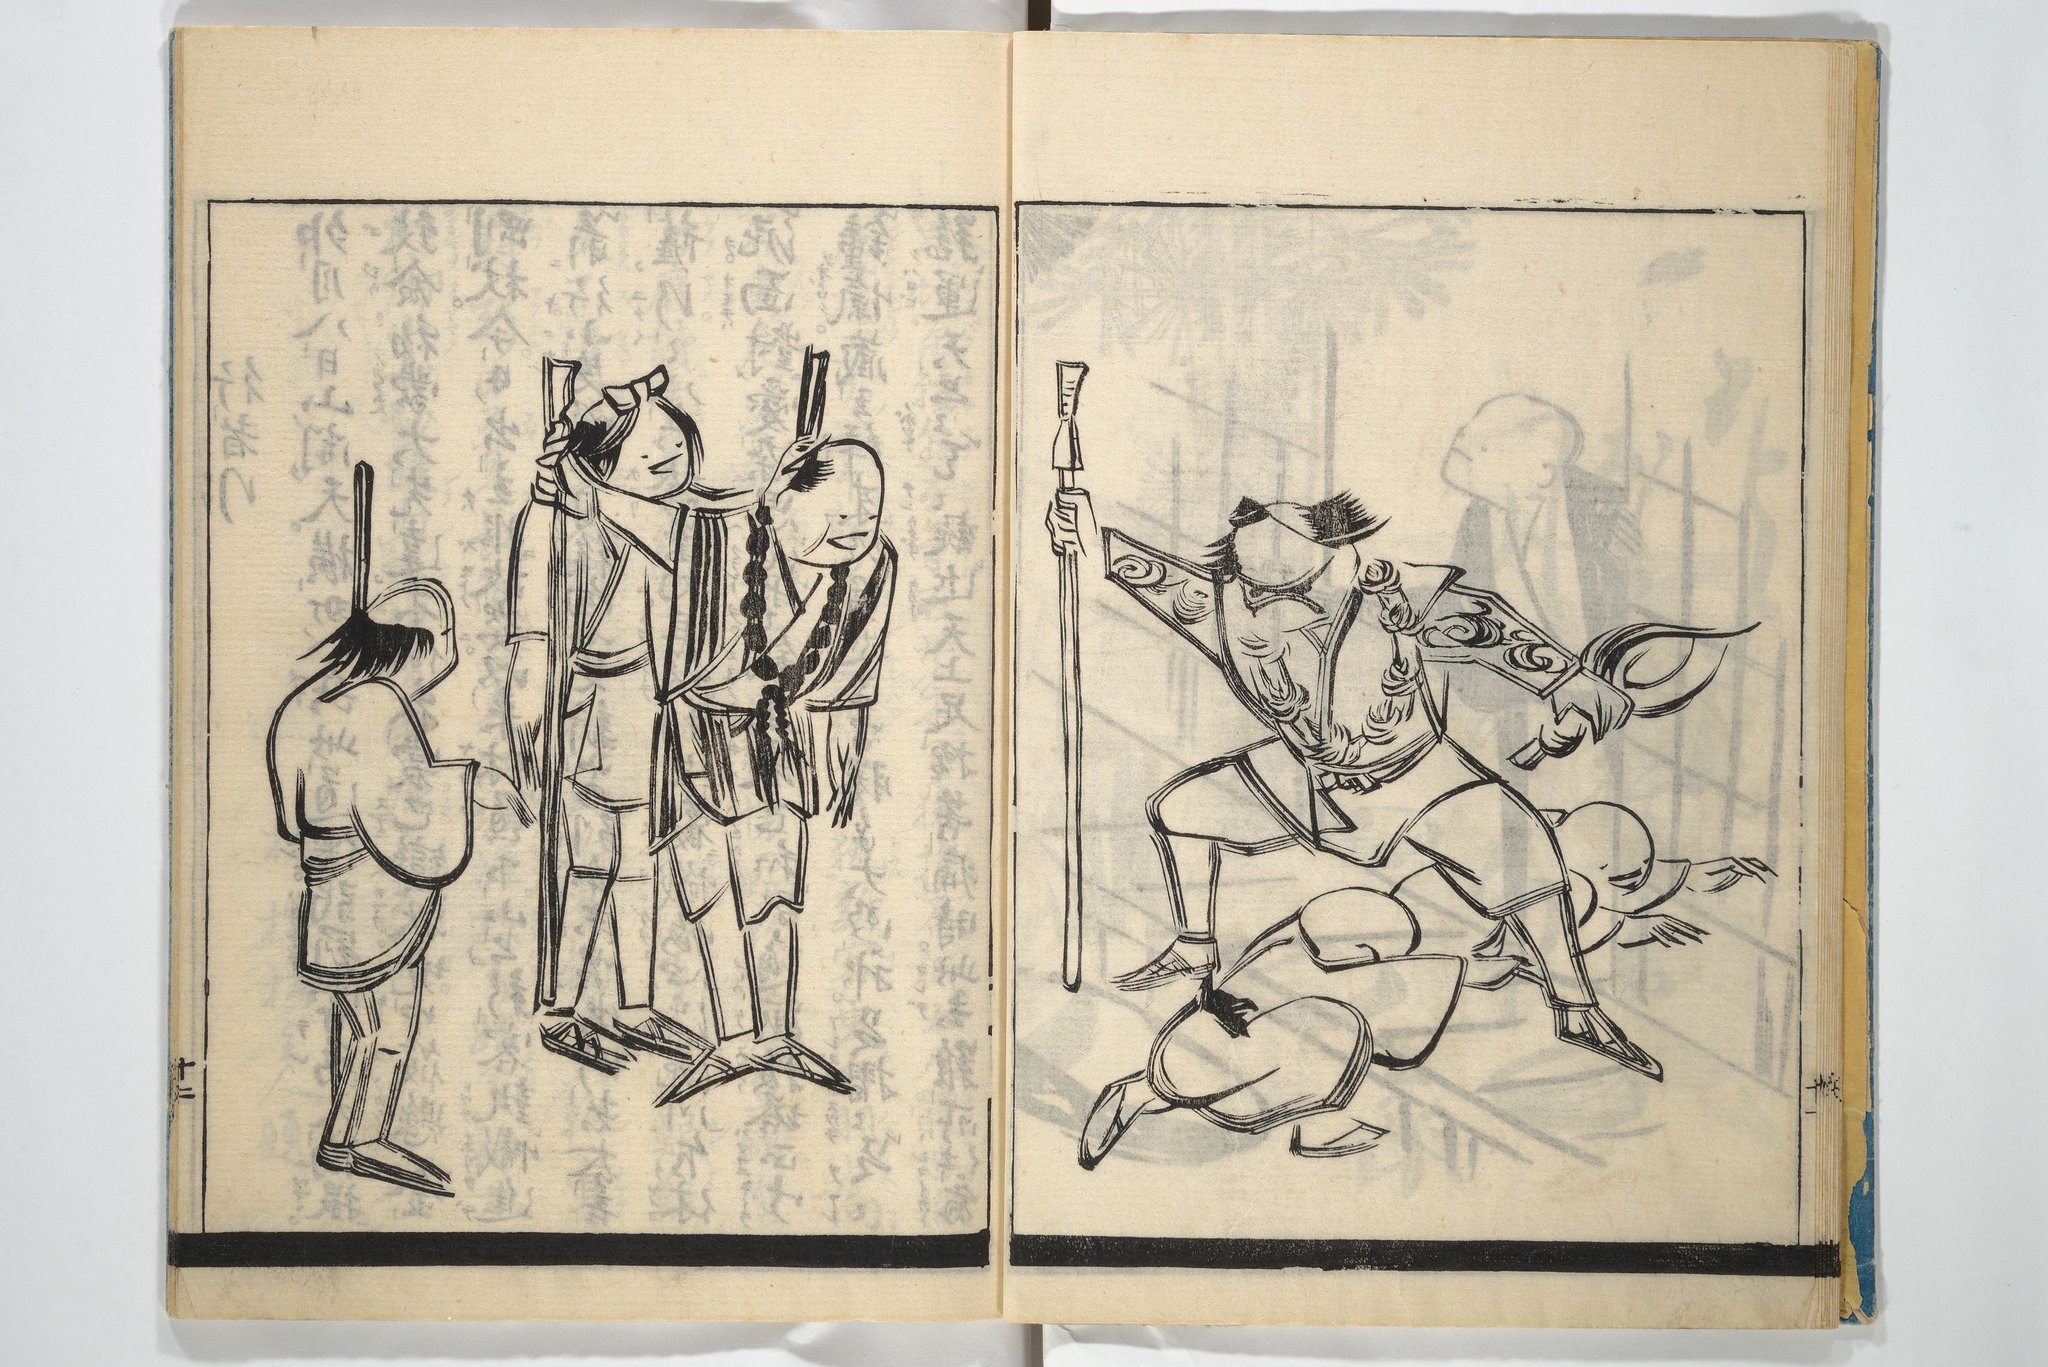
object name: illustrated book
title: Illustrated Poem Book (Katsura kasane} かつらかさね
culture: japanese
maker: nichōsai 耳鳥斎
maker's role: artist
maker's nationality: japanese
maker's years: 1780-1789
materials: ink, paper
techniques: woodblock print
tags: poetry,men